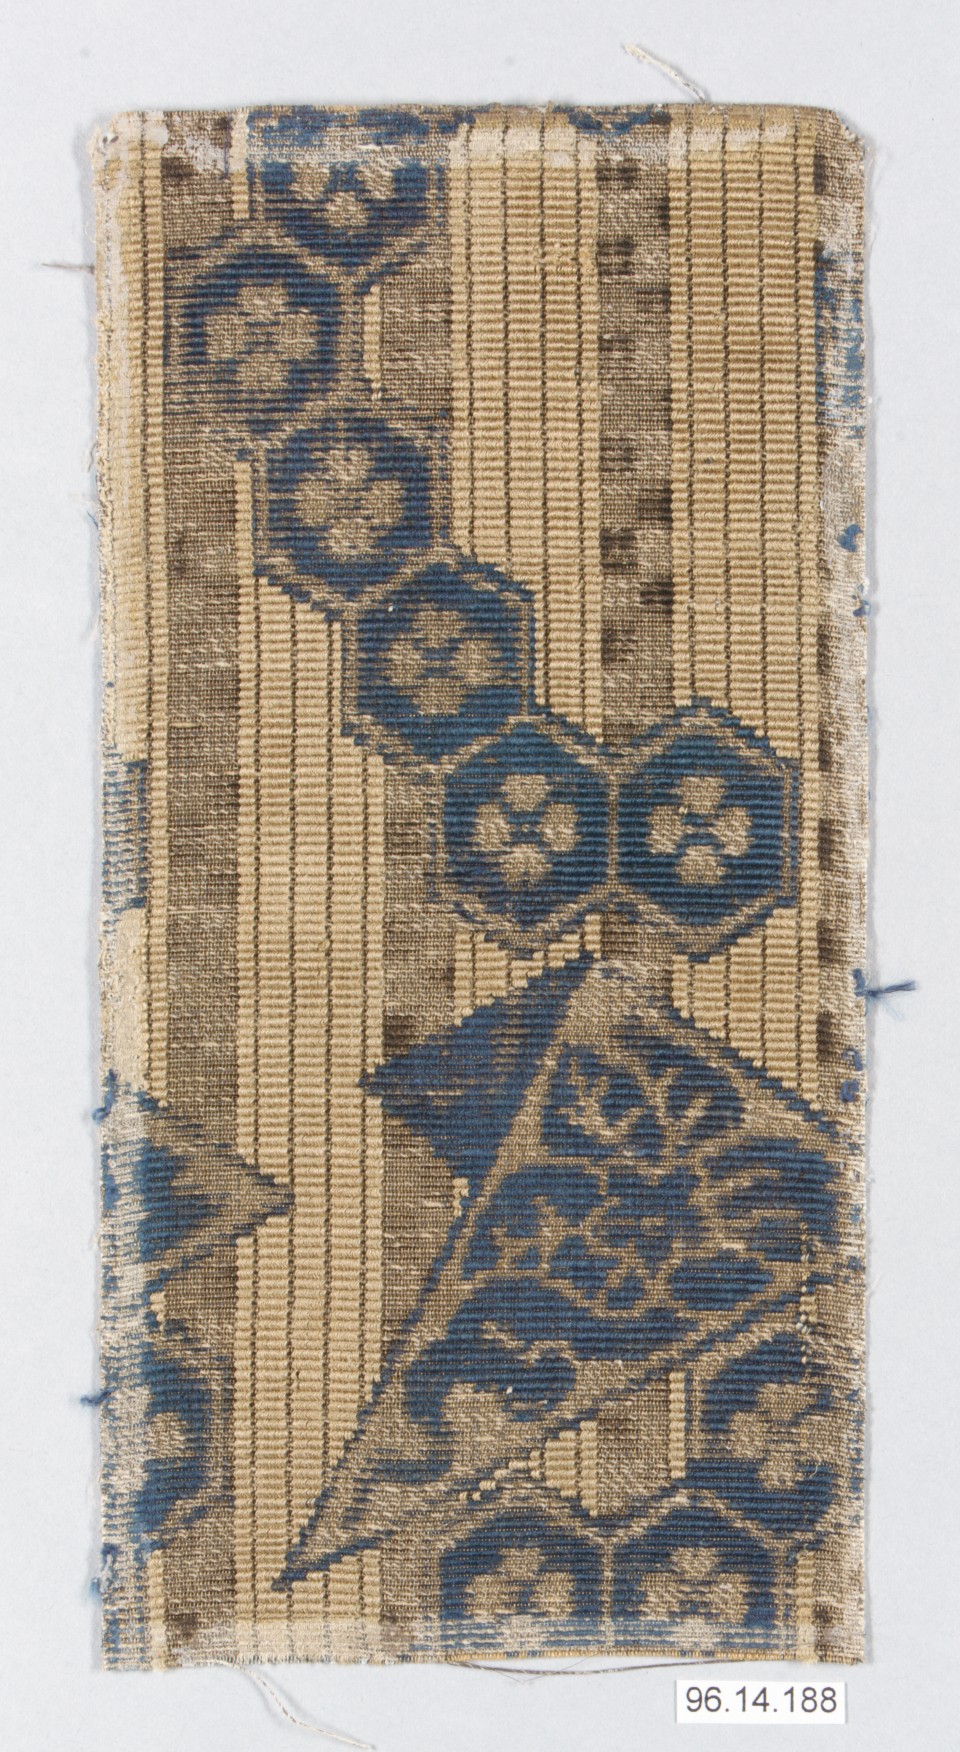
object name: piece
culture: japanese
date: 1801-1900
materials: silk